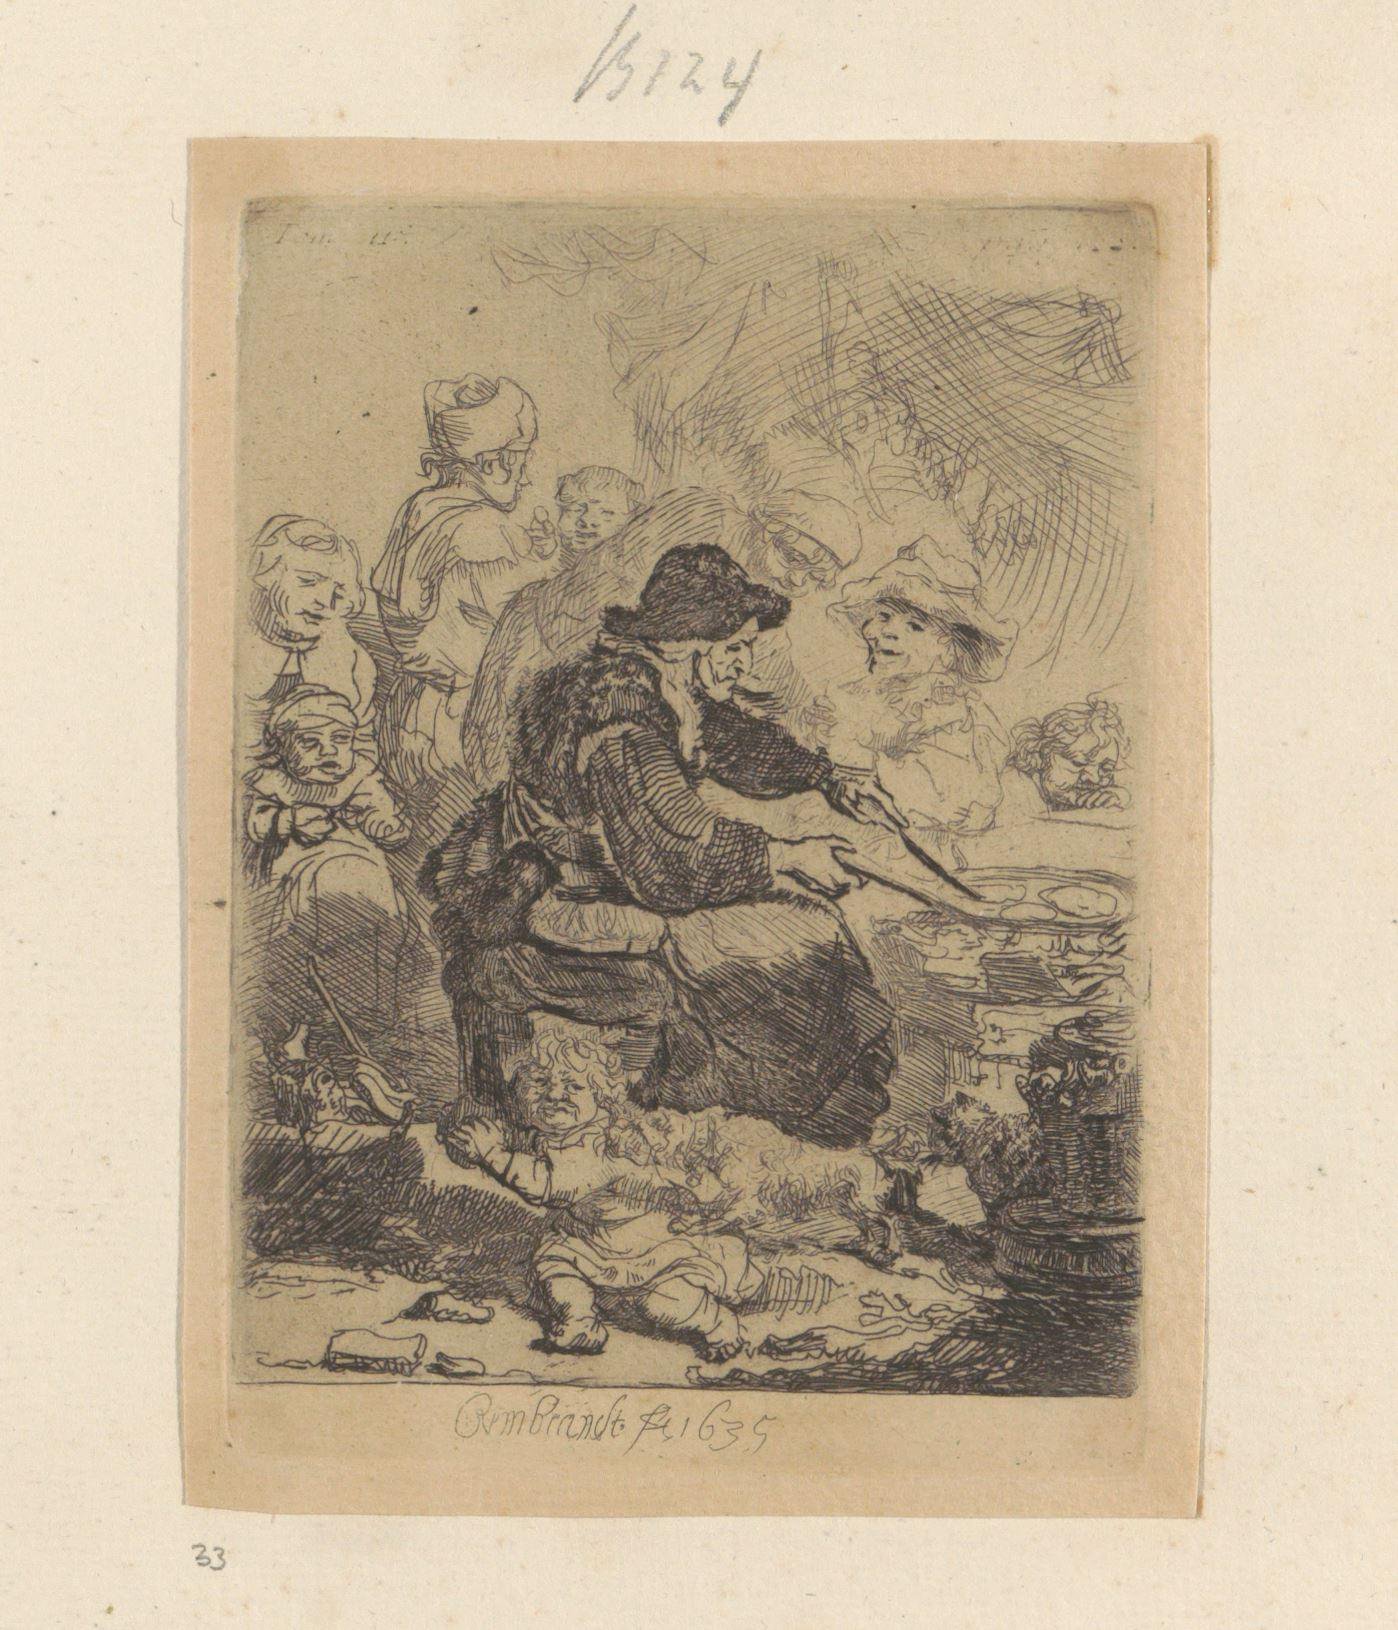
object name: print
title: Pannekoekenbakster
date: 1635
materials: paper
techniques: etching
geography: paris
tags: pancakes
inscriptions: date